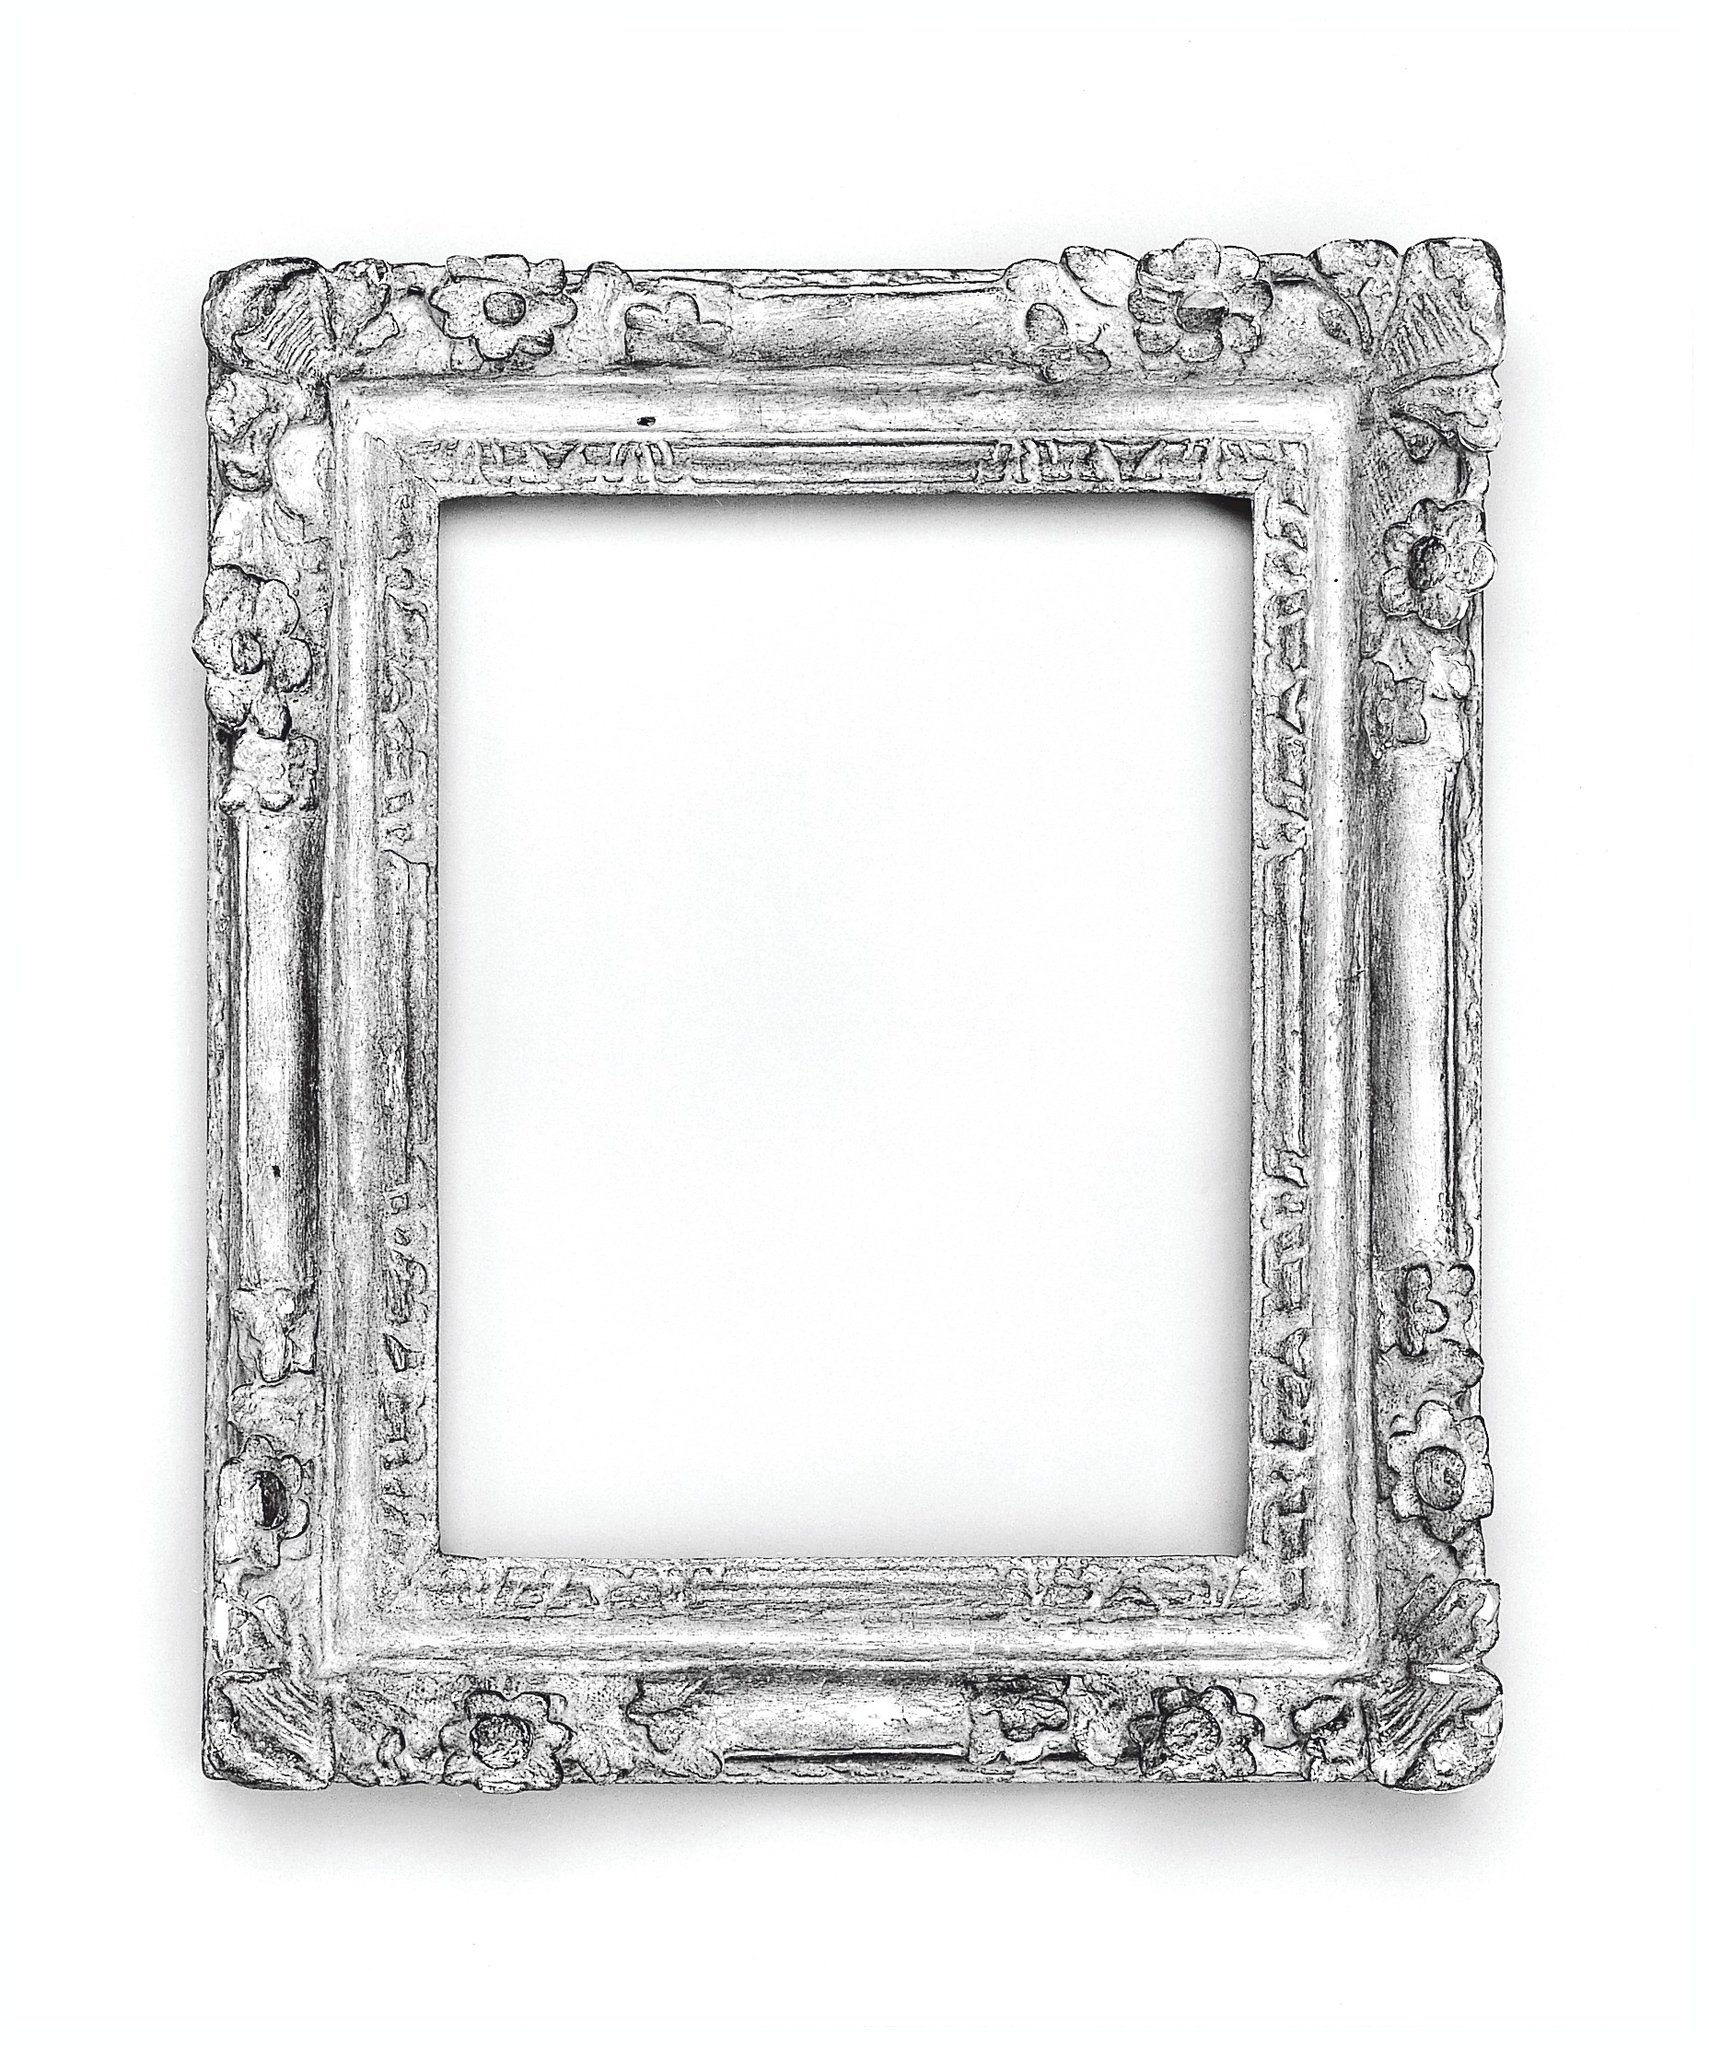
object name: frame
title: Ovolo frame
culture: french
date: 1660-1680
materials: wood